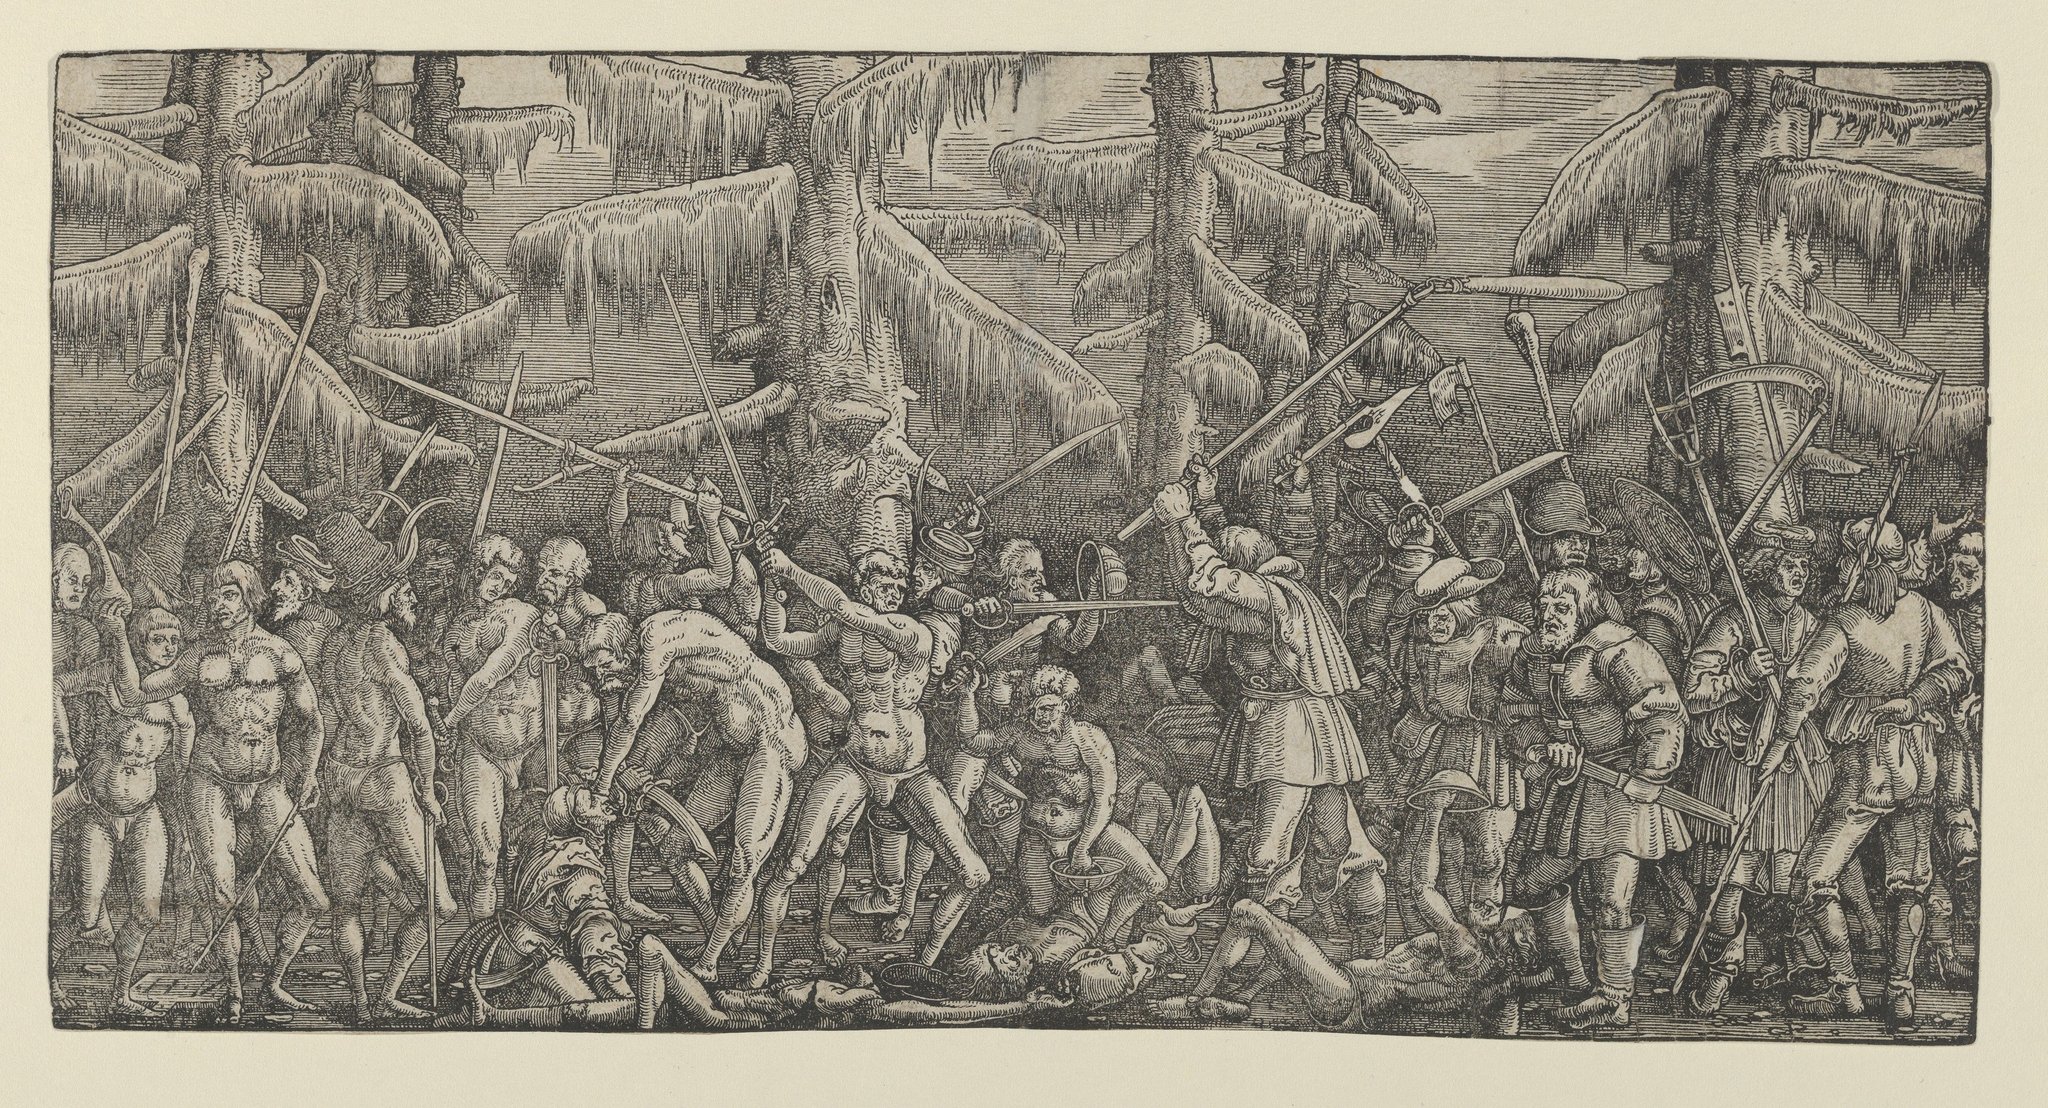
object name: print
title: Battle Between Peasants and Naked Men in a Forest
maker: master nh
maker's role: artist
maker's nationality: german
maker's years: 1495-1527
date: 1522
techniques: woodcut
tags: battles,men,male nudes,forests